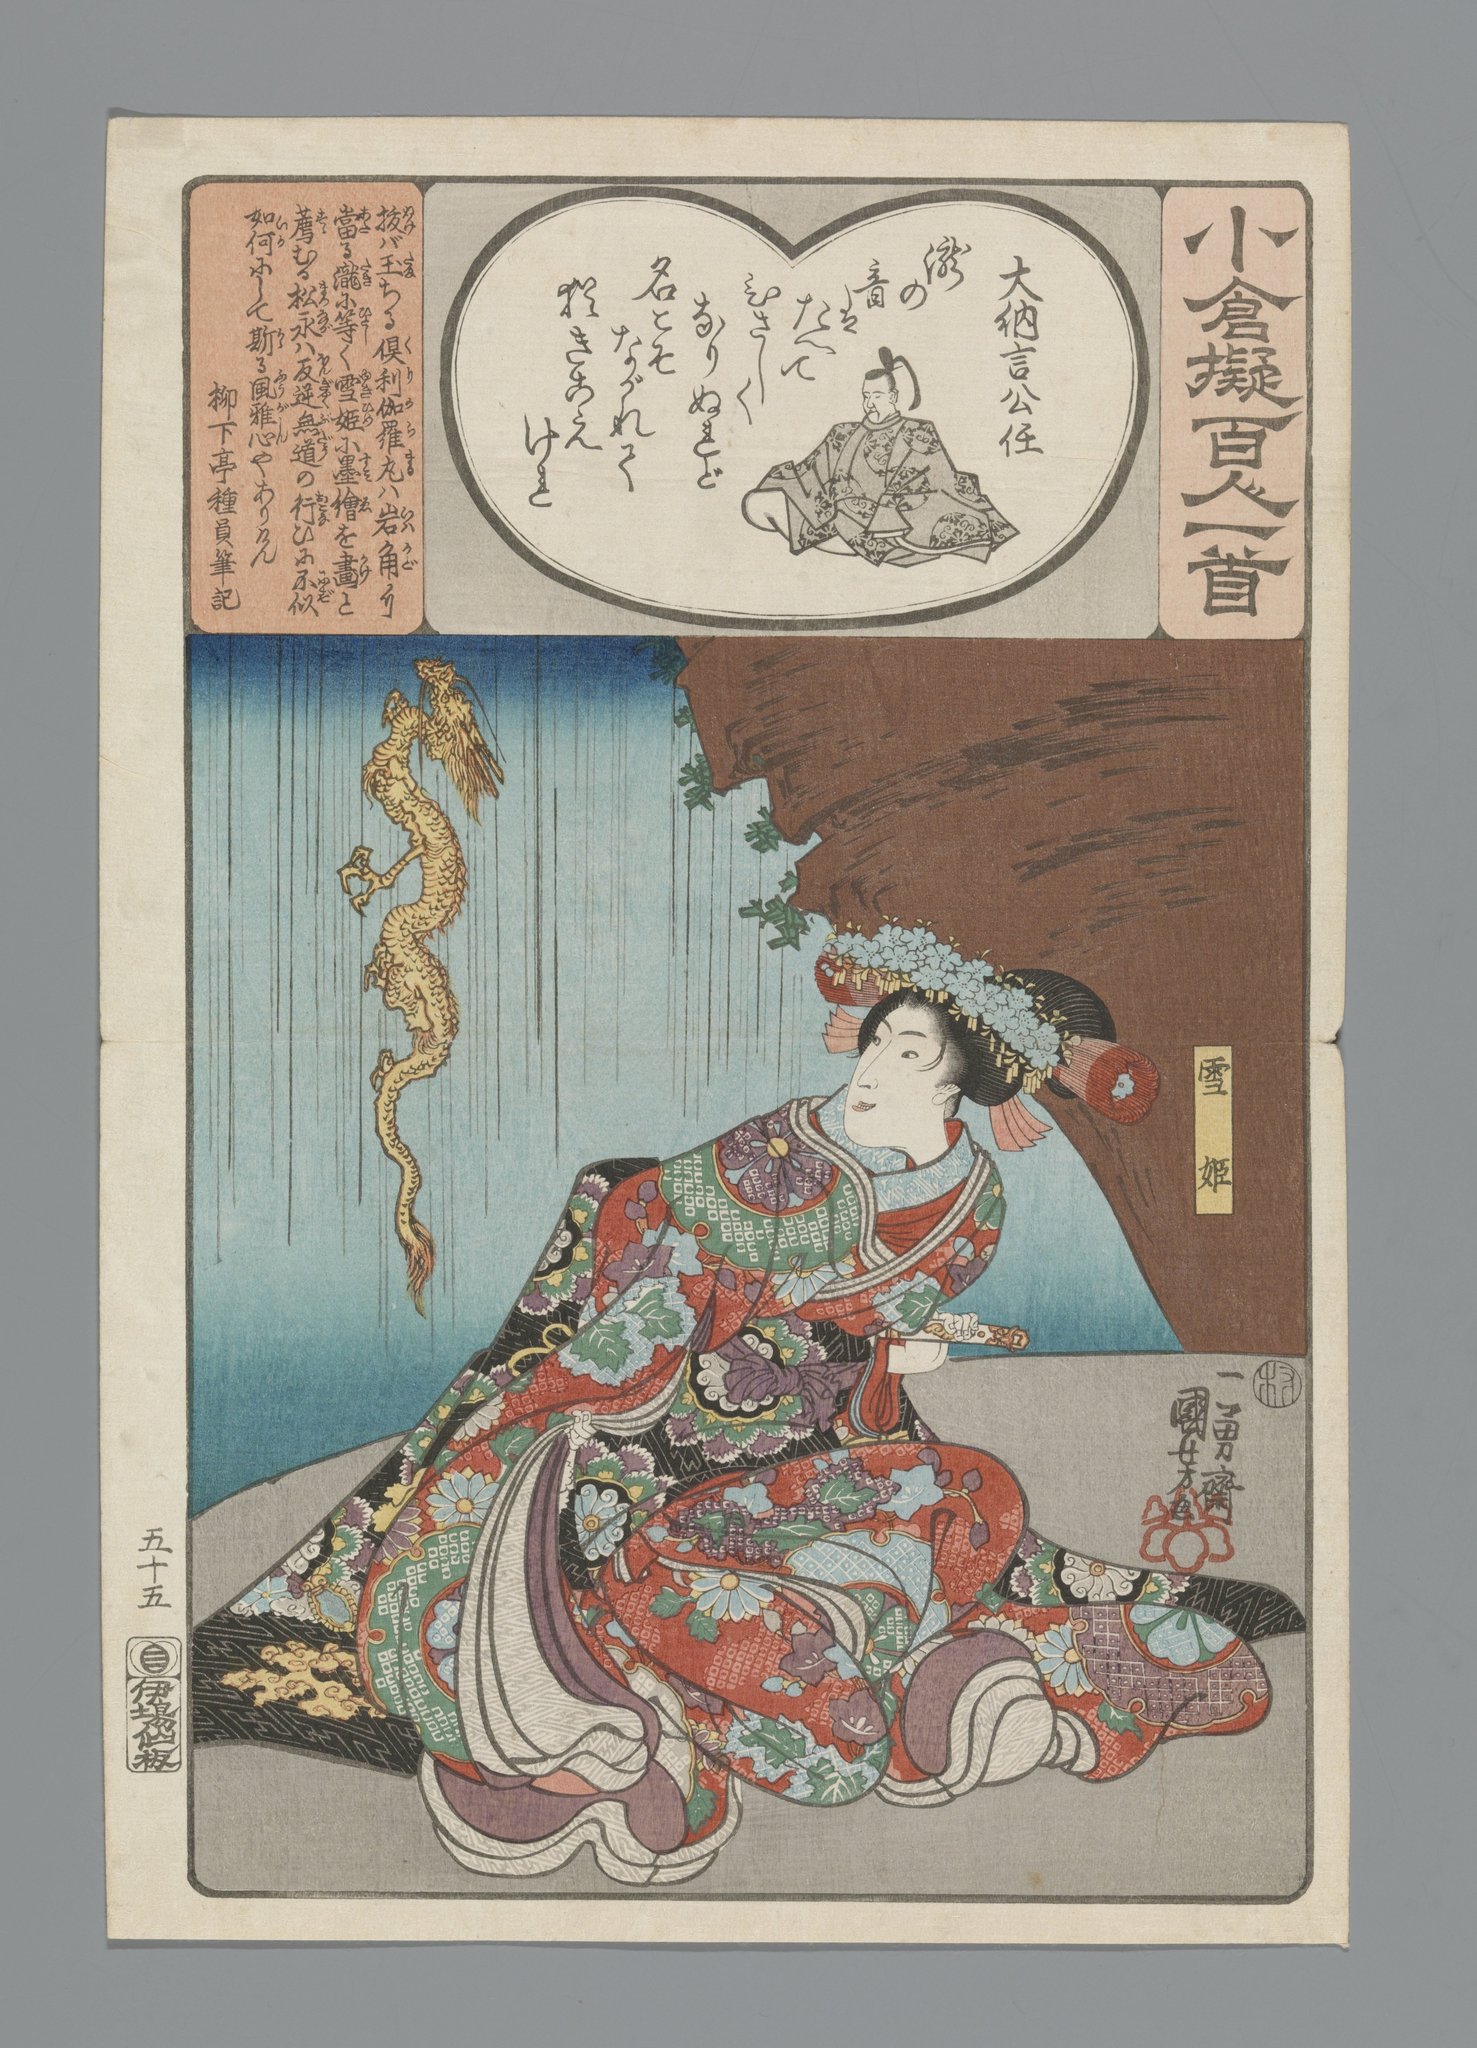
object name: print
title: Ogura Imitation of the One Hundred Poems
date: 1843-1845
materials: paper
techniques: woodcut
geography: japan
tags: waterfall, dragon, sitting on the ground - aa - female human figure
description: Prinses Yuki met het zwaard van haar vader achter haar rug, kijkt om naar een draak in de waterval. Scene uit een kabukitoneelstuk. Gedicht door Dainagon Kintô.